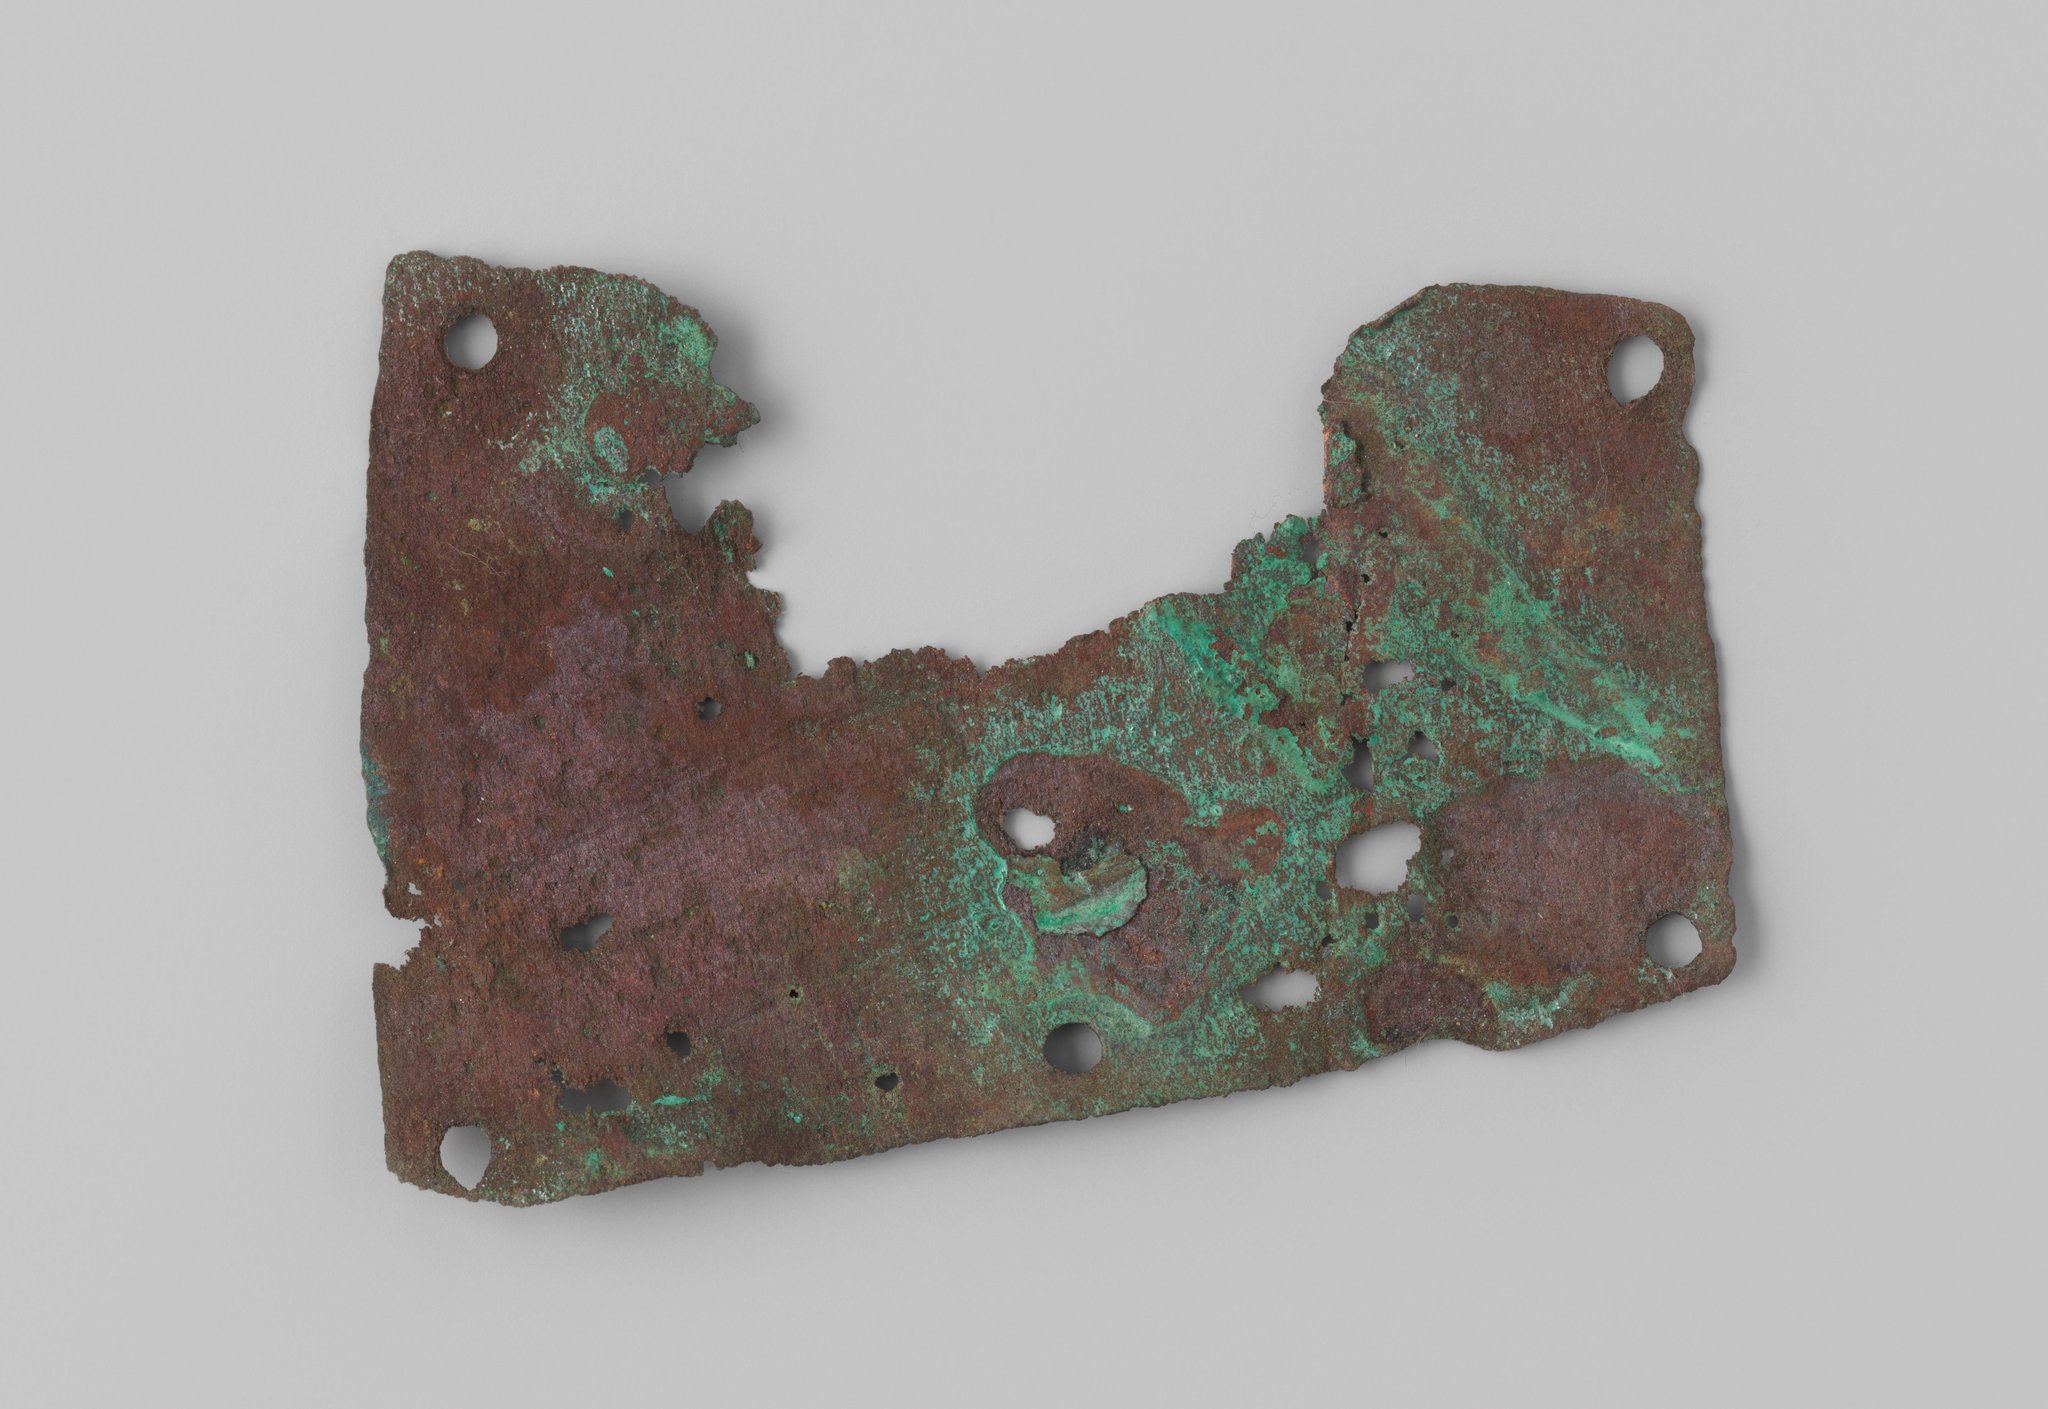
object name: musket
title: Kolfplaat van een musket uit het wrak van de Oost-Indiëvaarder Hollandia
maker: Anonymous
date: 1700-1743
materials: copper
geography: netherlands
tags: verenigde oostindische compagnie, hollandia (schip), annet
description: Musket, butt-plate; eroded, id. NG 1979-207H3071.